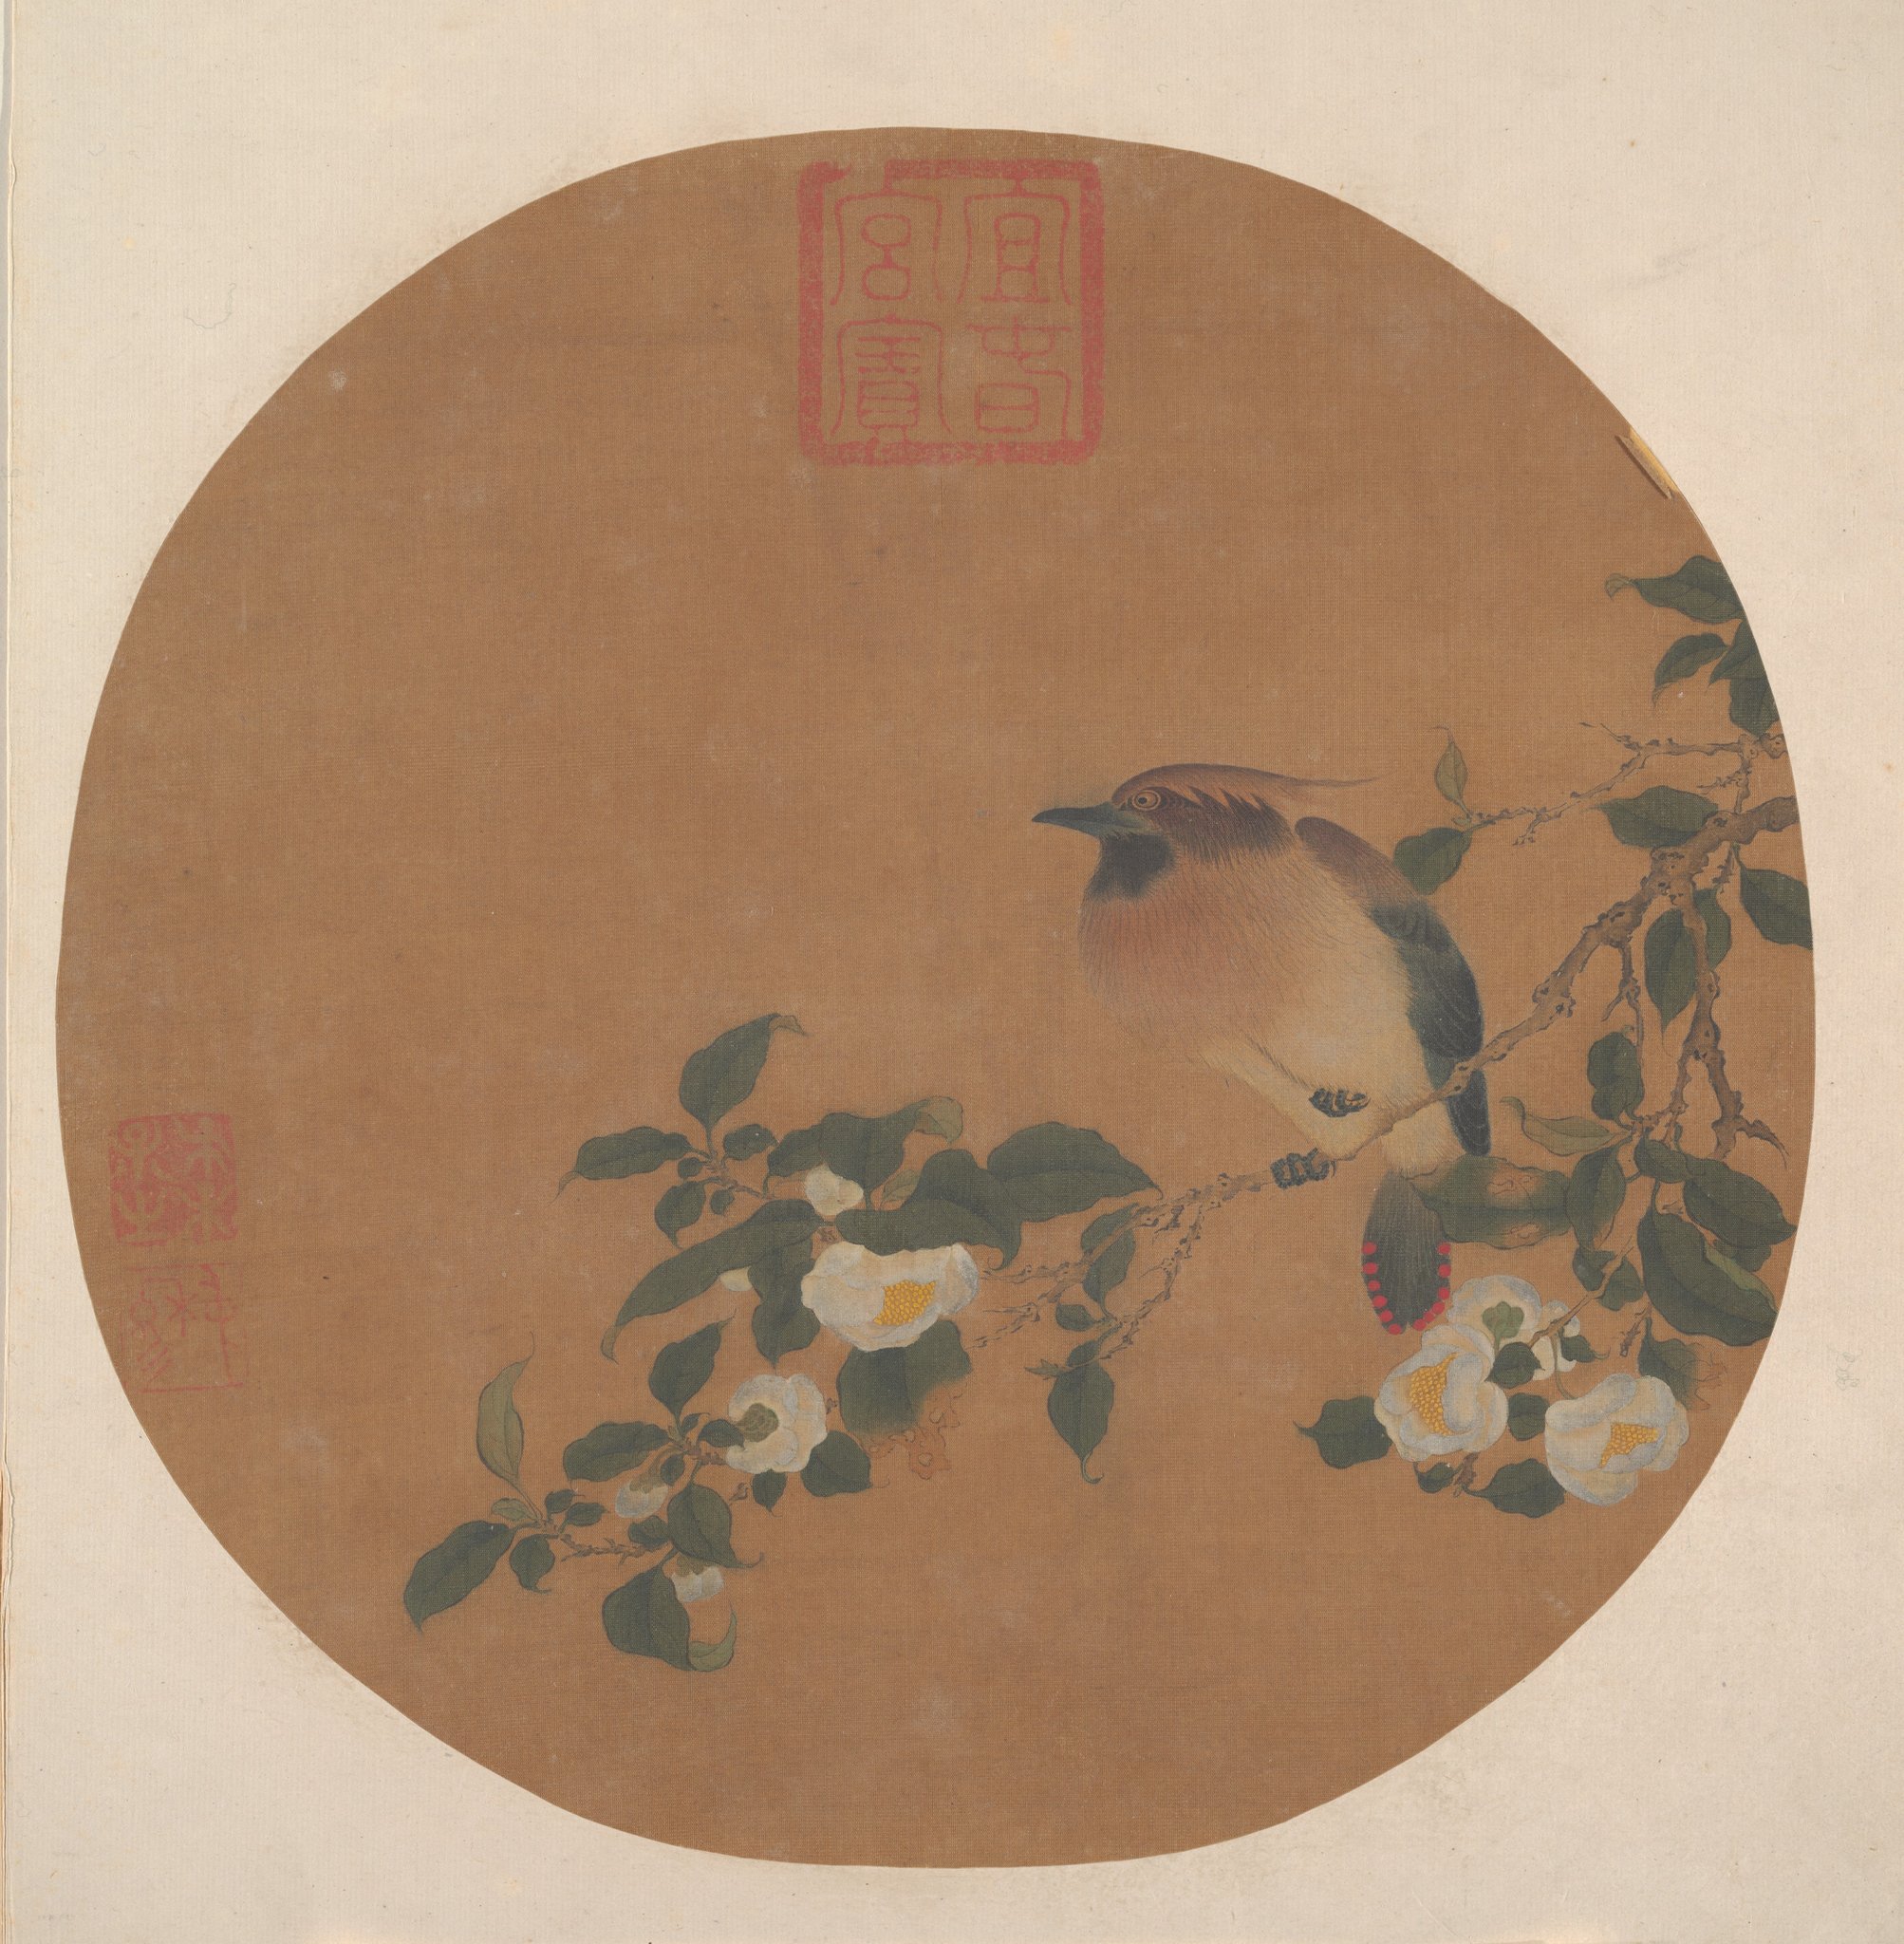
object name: fan mounted a an album leaf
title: Branch of Tree with Flowers and Bird of Waxwing Family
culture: chinese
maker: unidentified artist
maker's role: artist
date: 1644-1911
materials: ink, silk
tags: birds,flowers